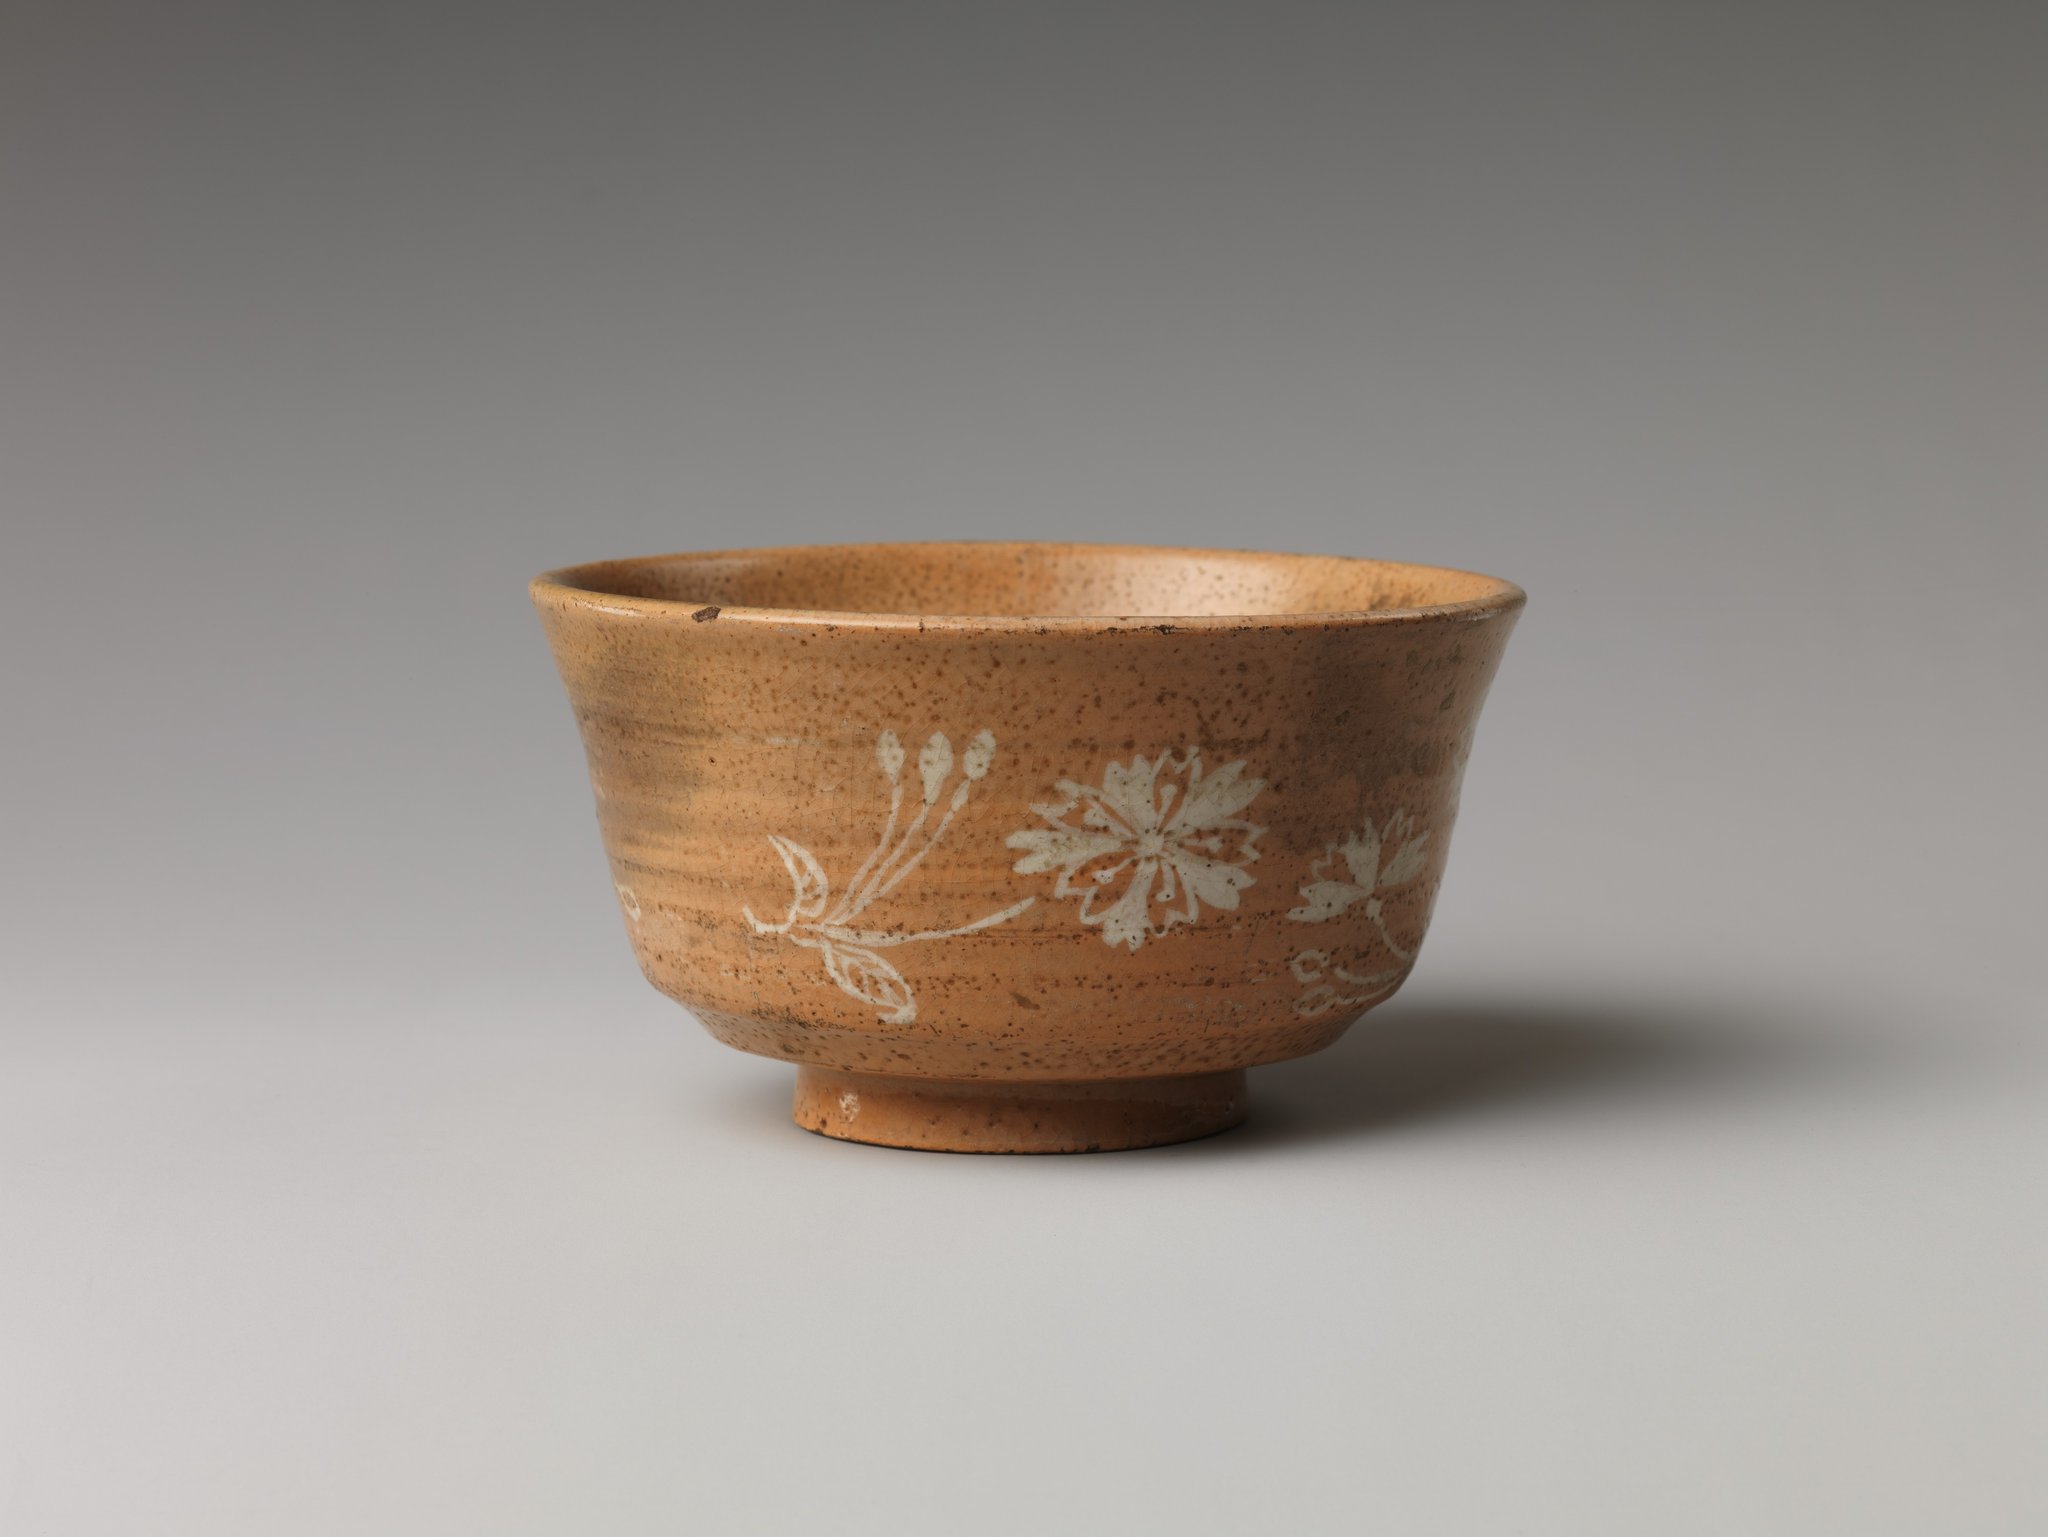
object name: teabowl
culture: japanese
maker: kikkutei ii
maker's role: artist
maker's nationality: japanese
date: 1850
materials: clay, glaze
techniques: underglaze